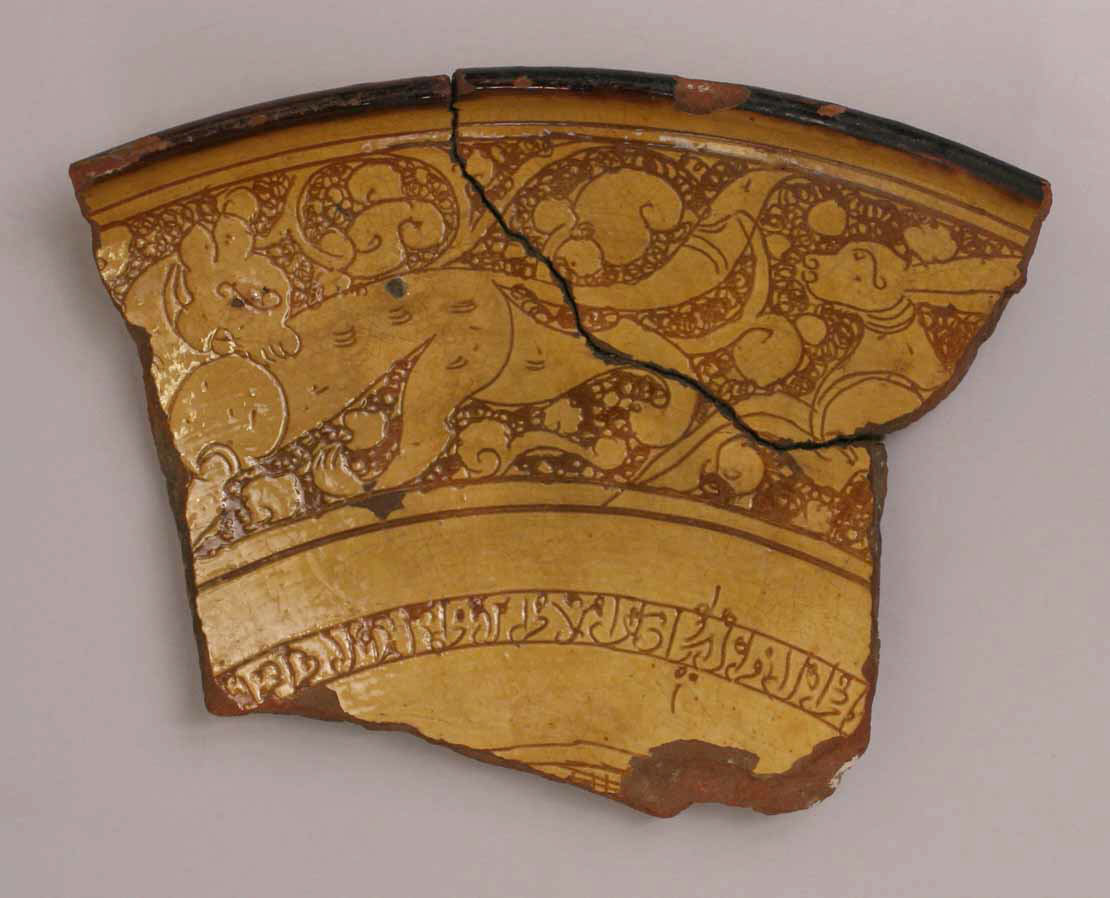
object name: fragment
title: Ceramic Fragment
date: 1301-1400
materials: glaze, stonepaste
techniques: painting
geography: egypt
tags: animals